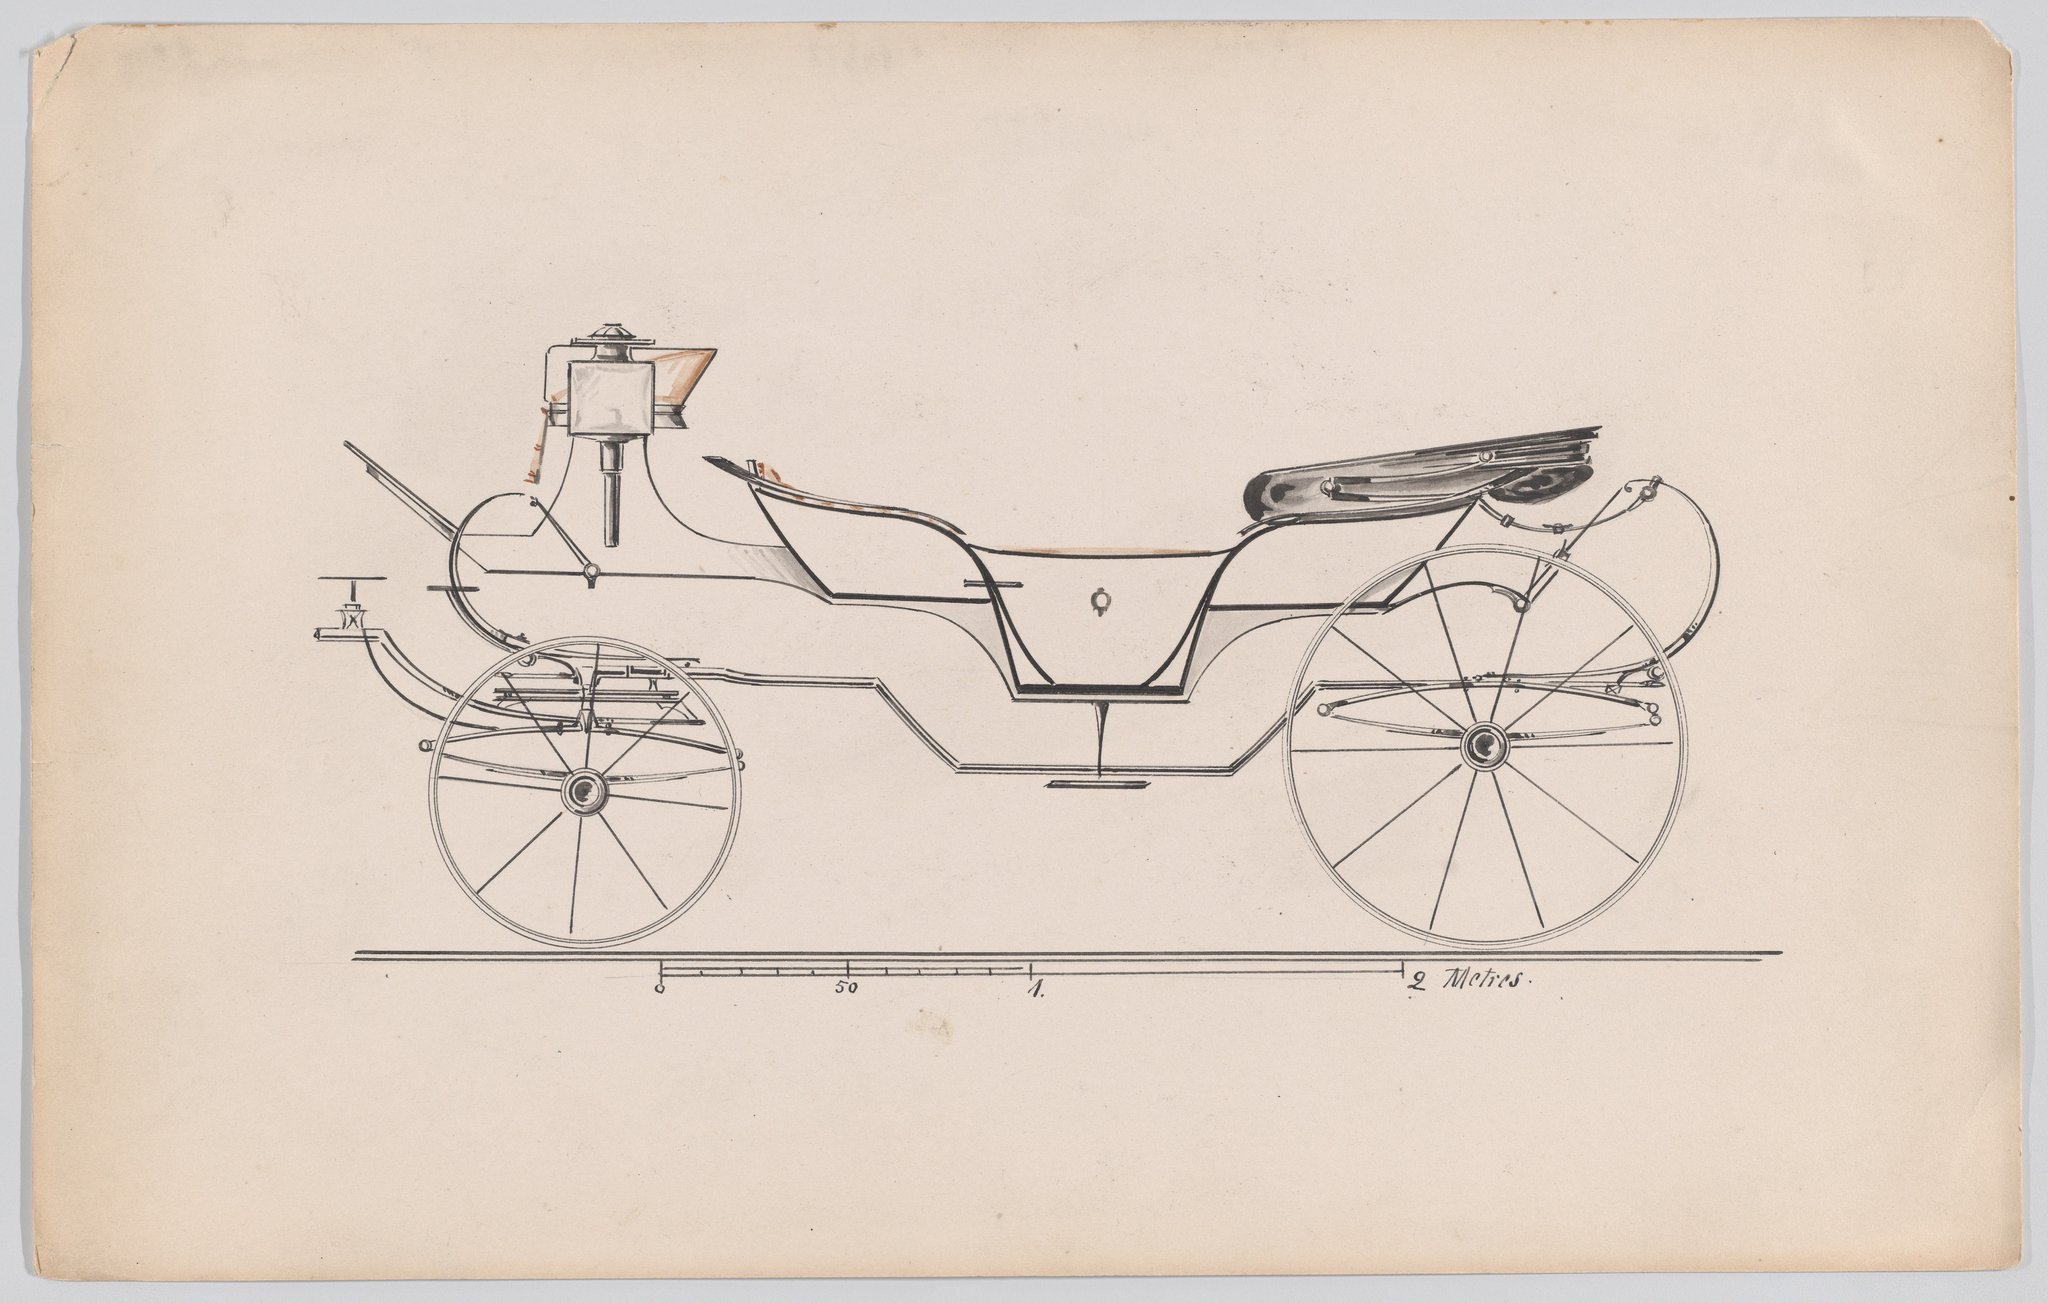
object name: drawing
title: Design for Vis-à-Vis (French?)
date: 1880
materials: gouache, ink, watercolor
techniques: pen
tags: carriages